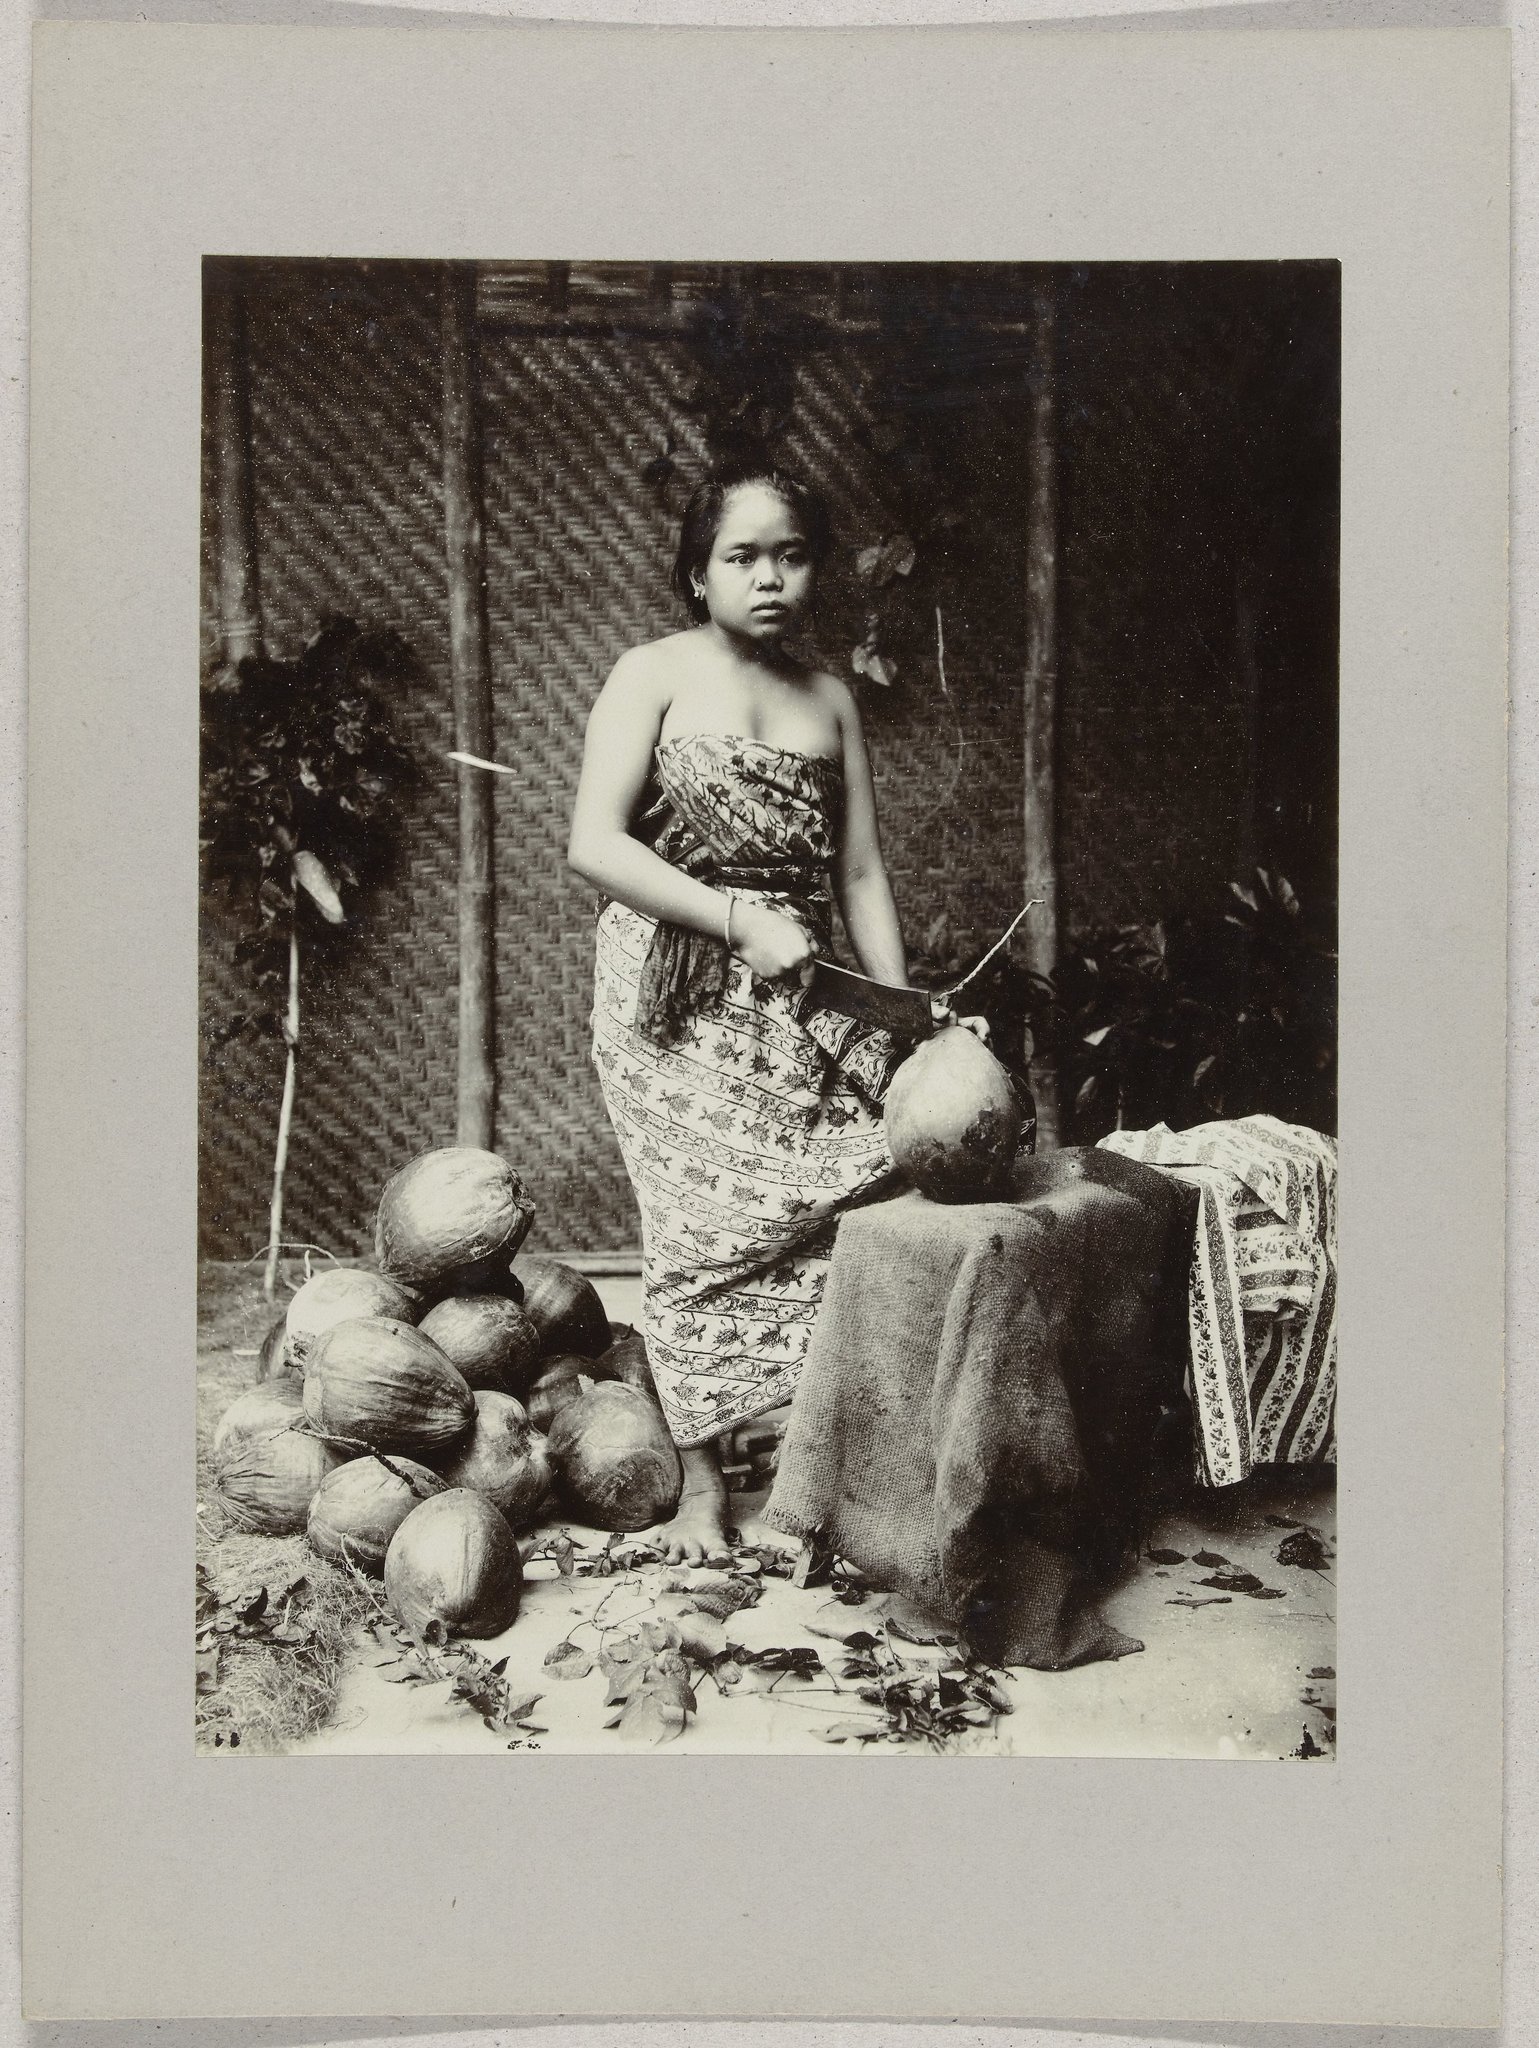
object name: photograph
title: Studioportret van een meisje met kokosnoten in Nederlands-Indië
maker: Anonymous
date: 1895-1915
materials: cardboard, paper, photographic support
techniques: gelatin silver print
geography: dutch east indies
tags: indonesia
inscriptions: number: ‘31’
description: Portret van een meisje met kokosnoten, gemaakt in een studio, Nederlands-Indië